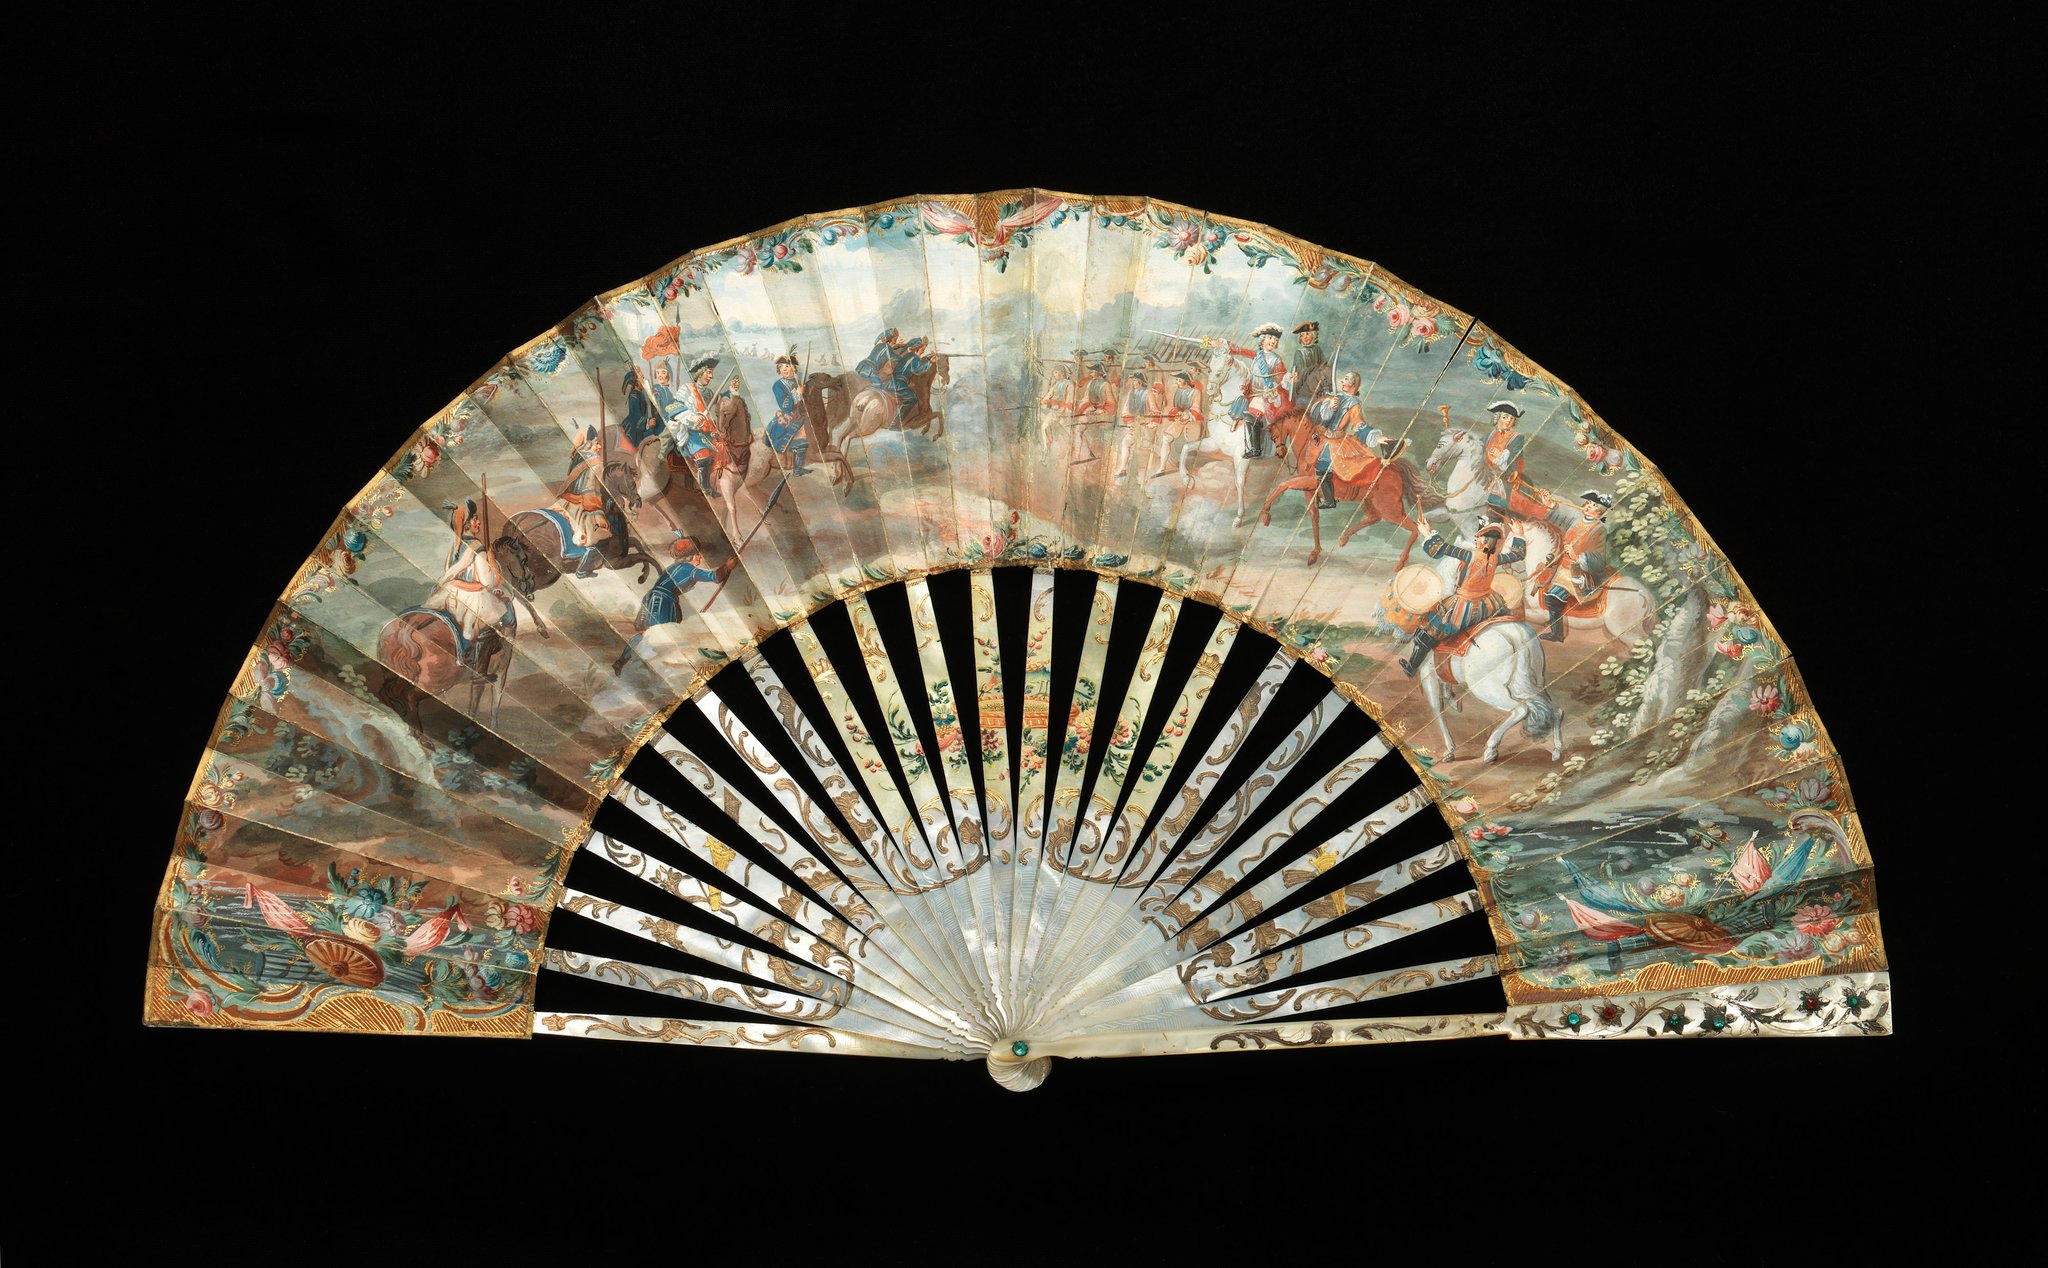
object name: fan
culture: french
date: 1710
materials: gouache, metal, mother of pearl, paper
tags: battles,men,horses